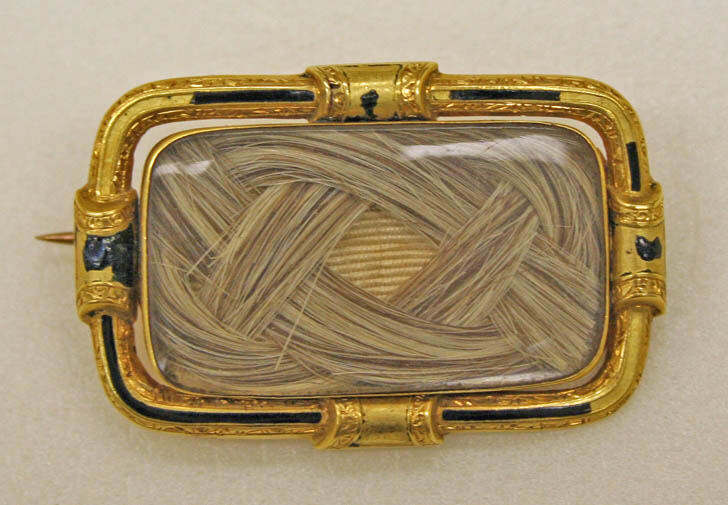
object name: brooch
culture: french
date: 1844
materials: gold